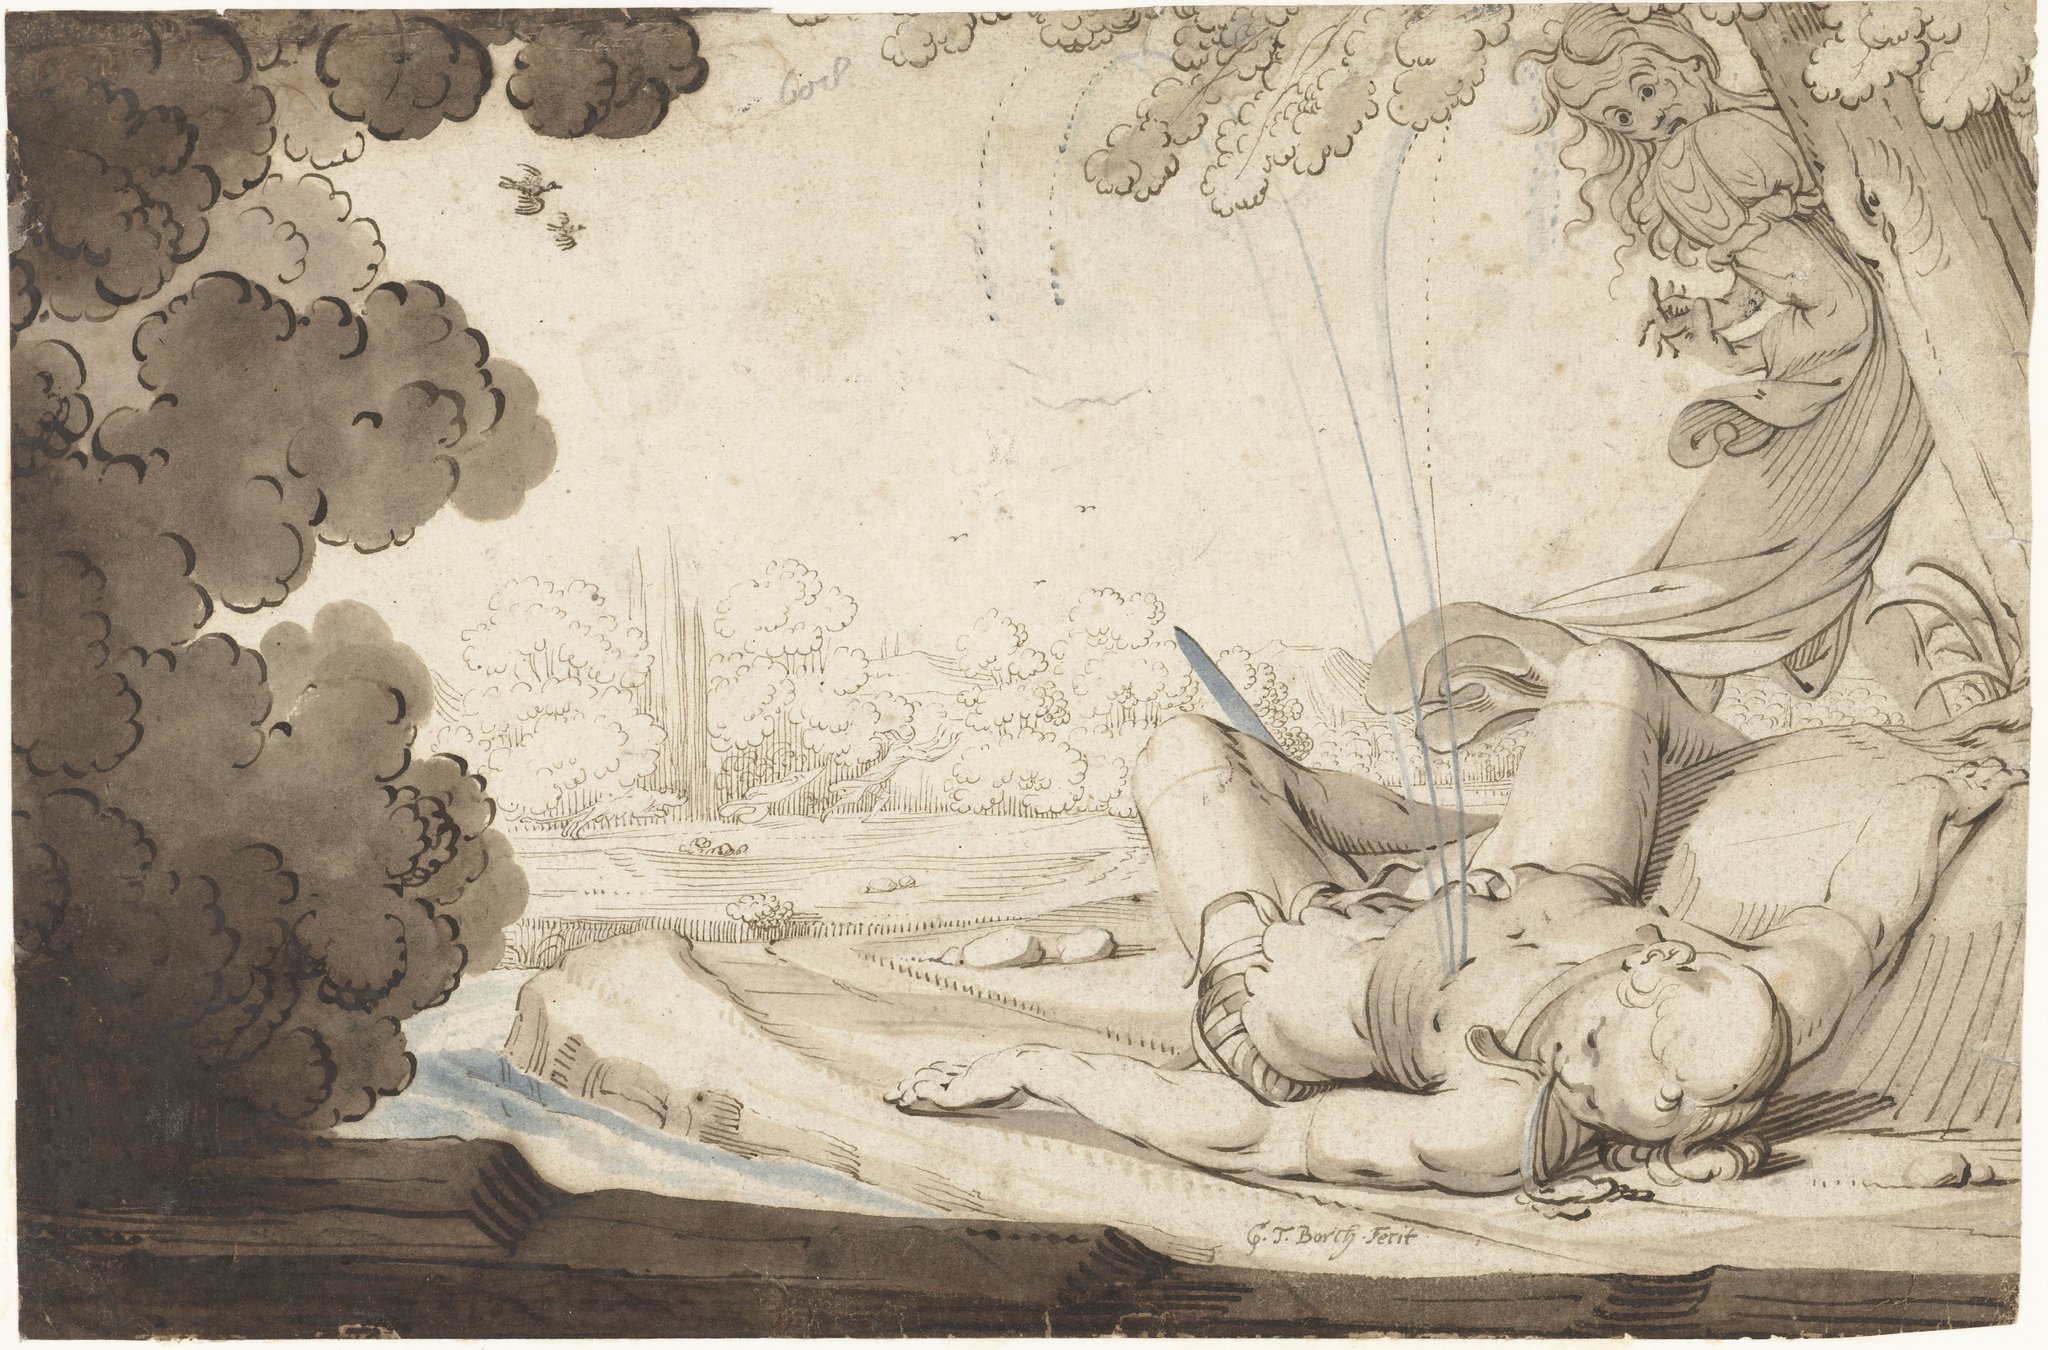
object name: drawing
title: Thisbe ontdekt de dode Piramus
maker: gerard ter borch (i)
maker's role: draughtsman, print maker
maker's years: 1584-1662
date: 1620-1629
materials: ink, paper, watercolor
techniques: brush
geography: zwolle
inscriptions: annotation: ‘Piramus en Thisbe’, signature: ‘G.T.Borch.Fecit’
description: Naar Ovidius Naso, Publius: Metamorphosen (Libri...).